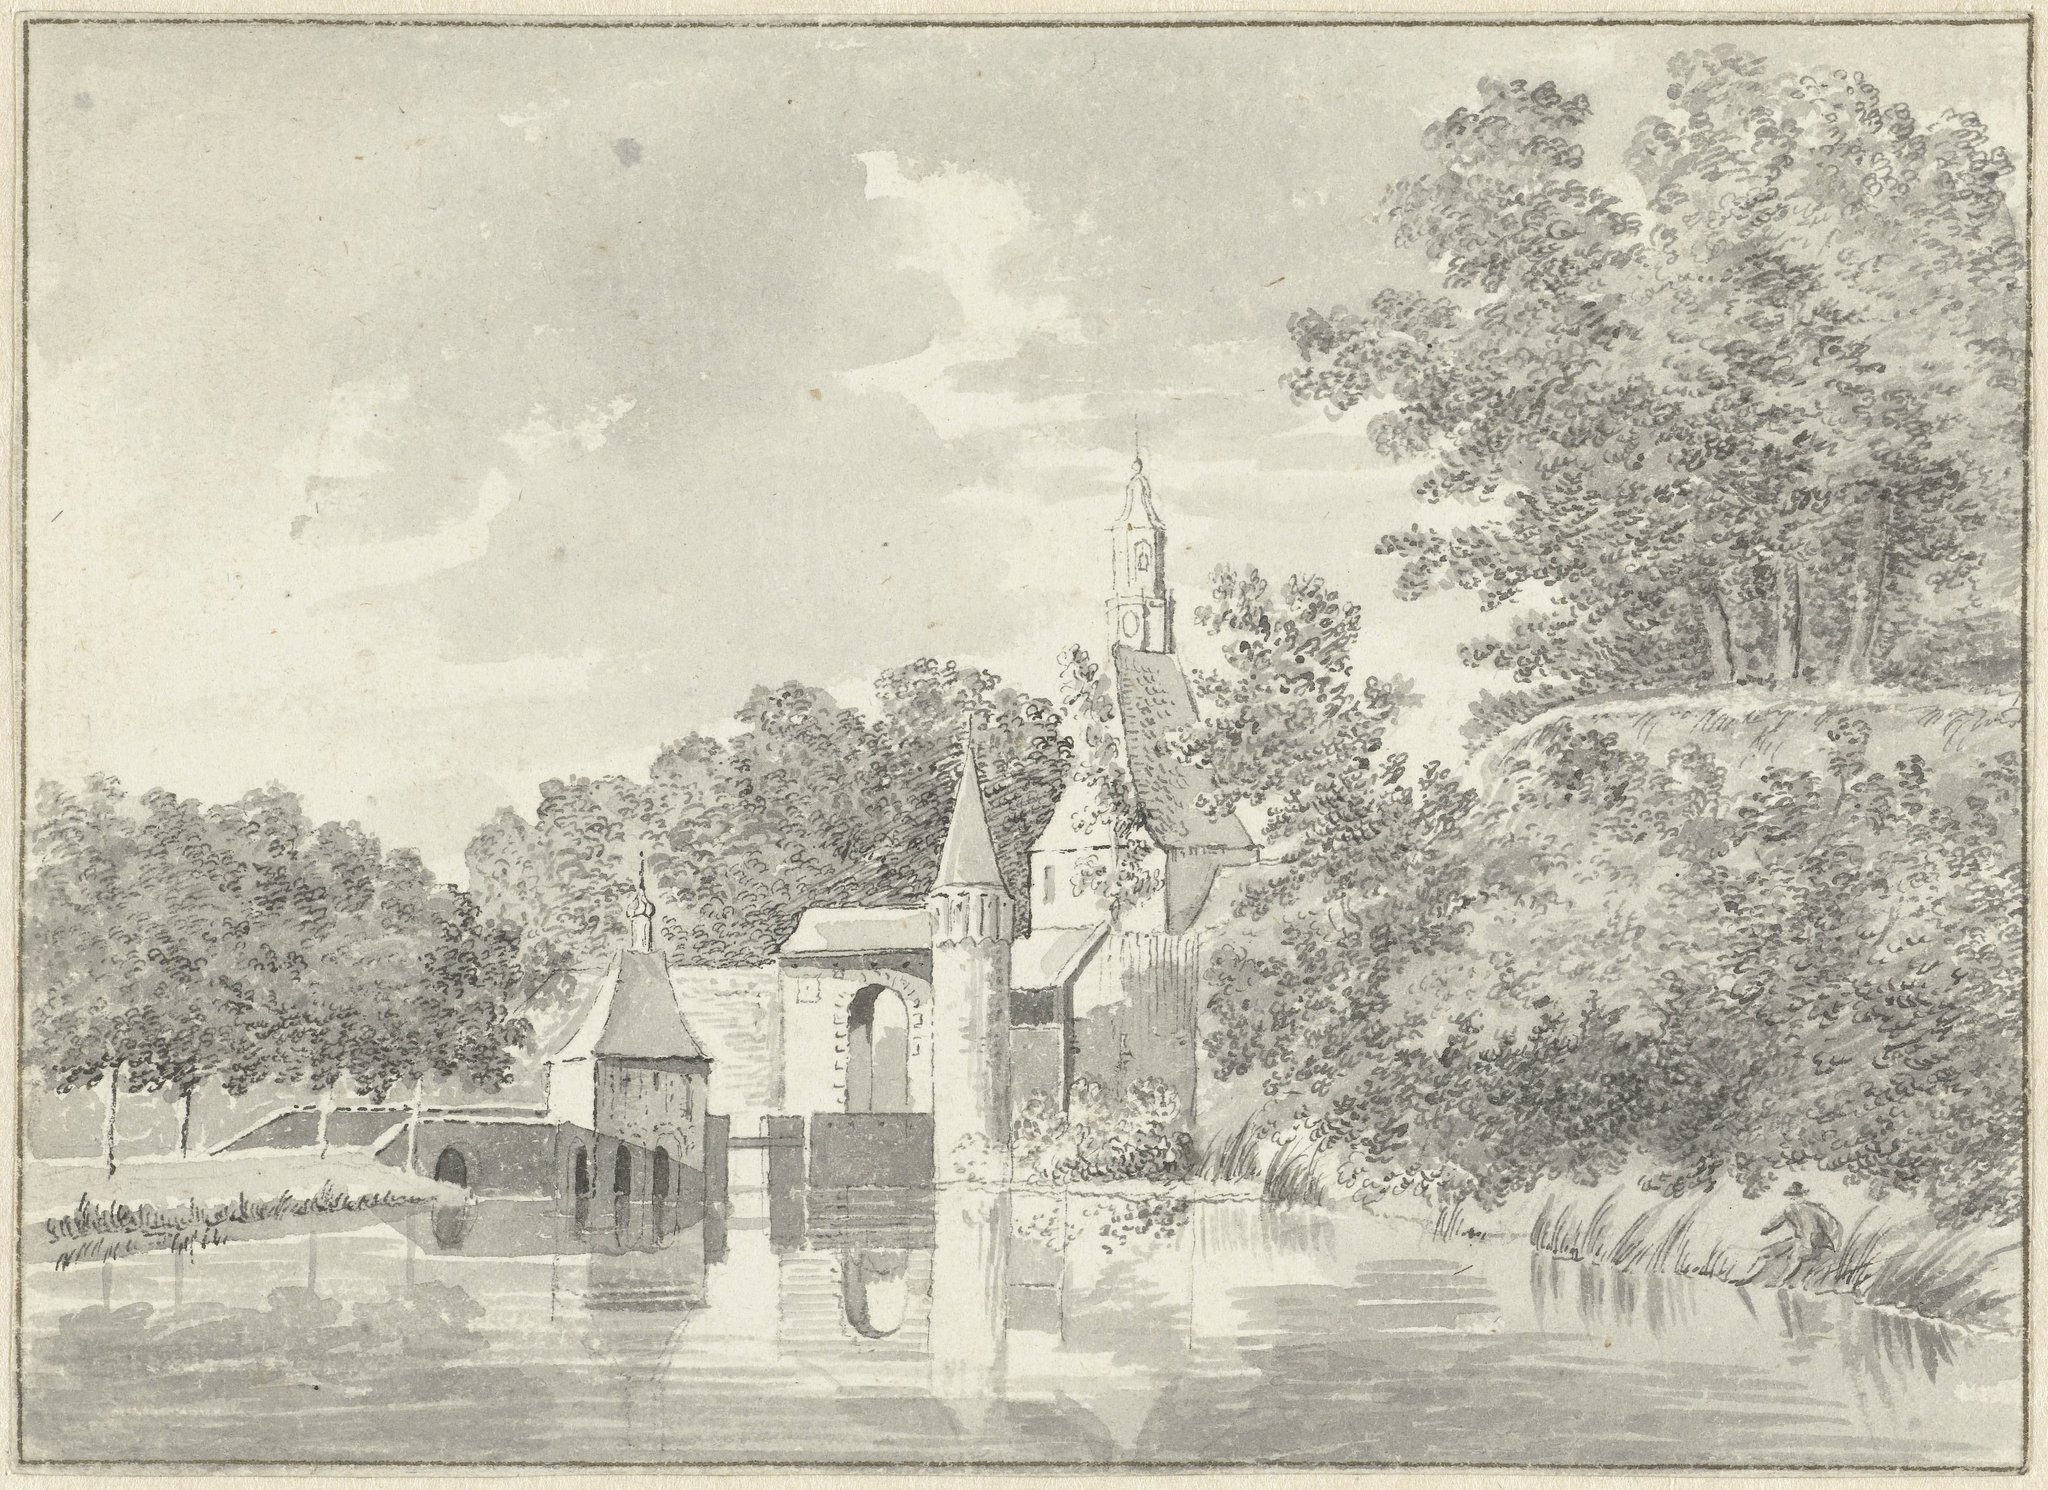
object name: drawing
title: Burensche Poort te Tiel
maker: hendrik tavenier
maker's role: draughtsman, print maker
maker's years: 1734-1807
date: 1744-1807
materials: ink, paper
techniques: brush, pen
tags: city-gate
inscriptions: inscription: ‘H: Tavenier / [andere hand:] burengse poort te Tiel’